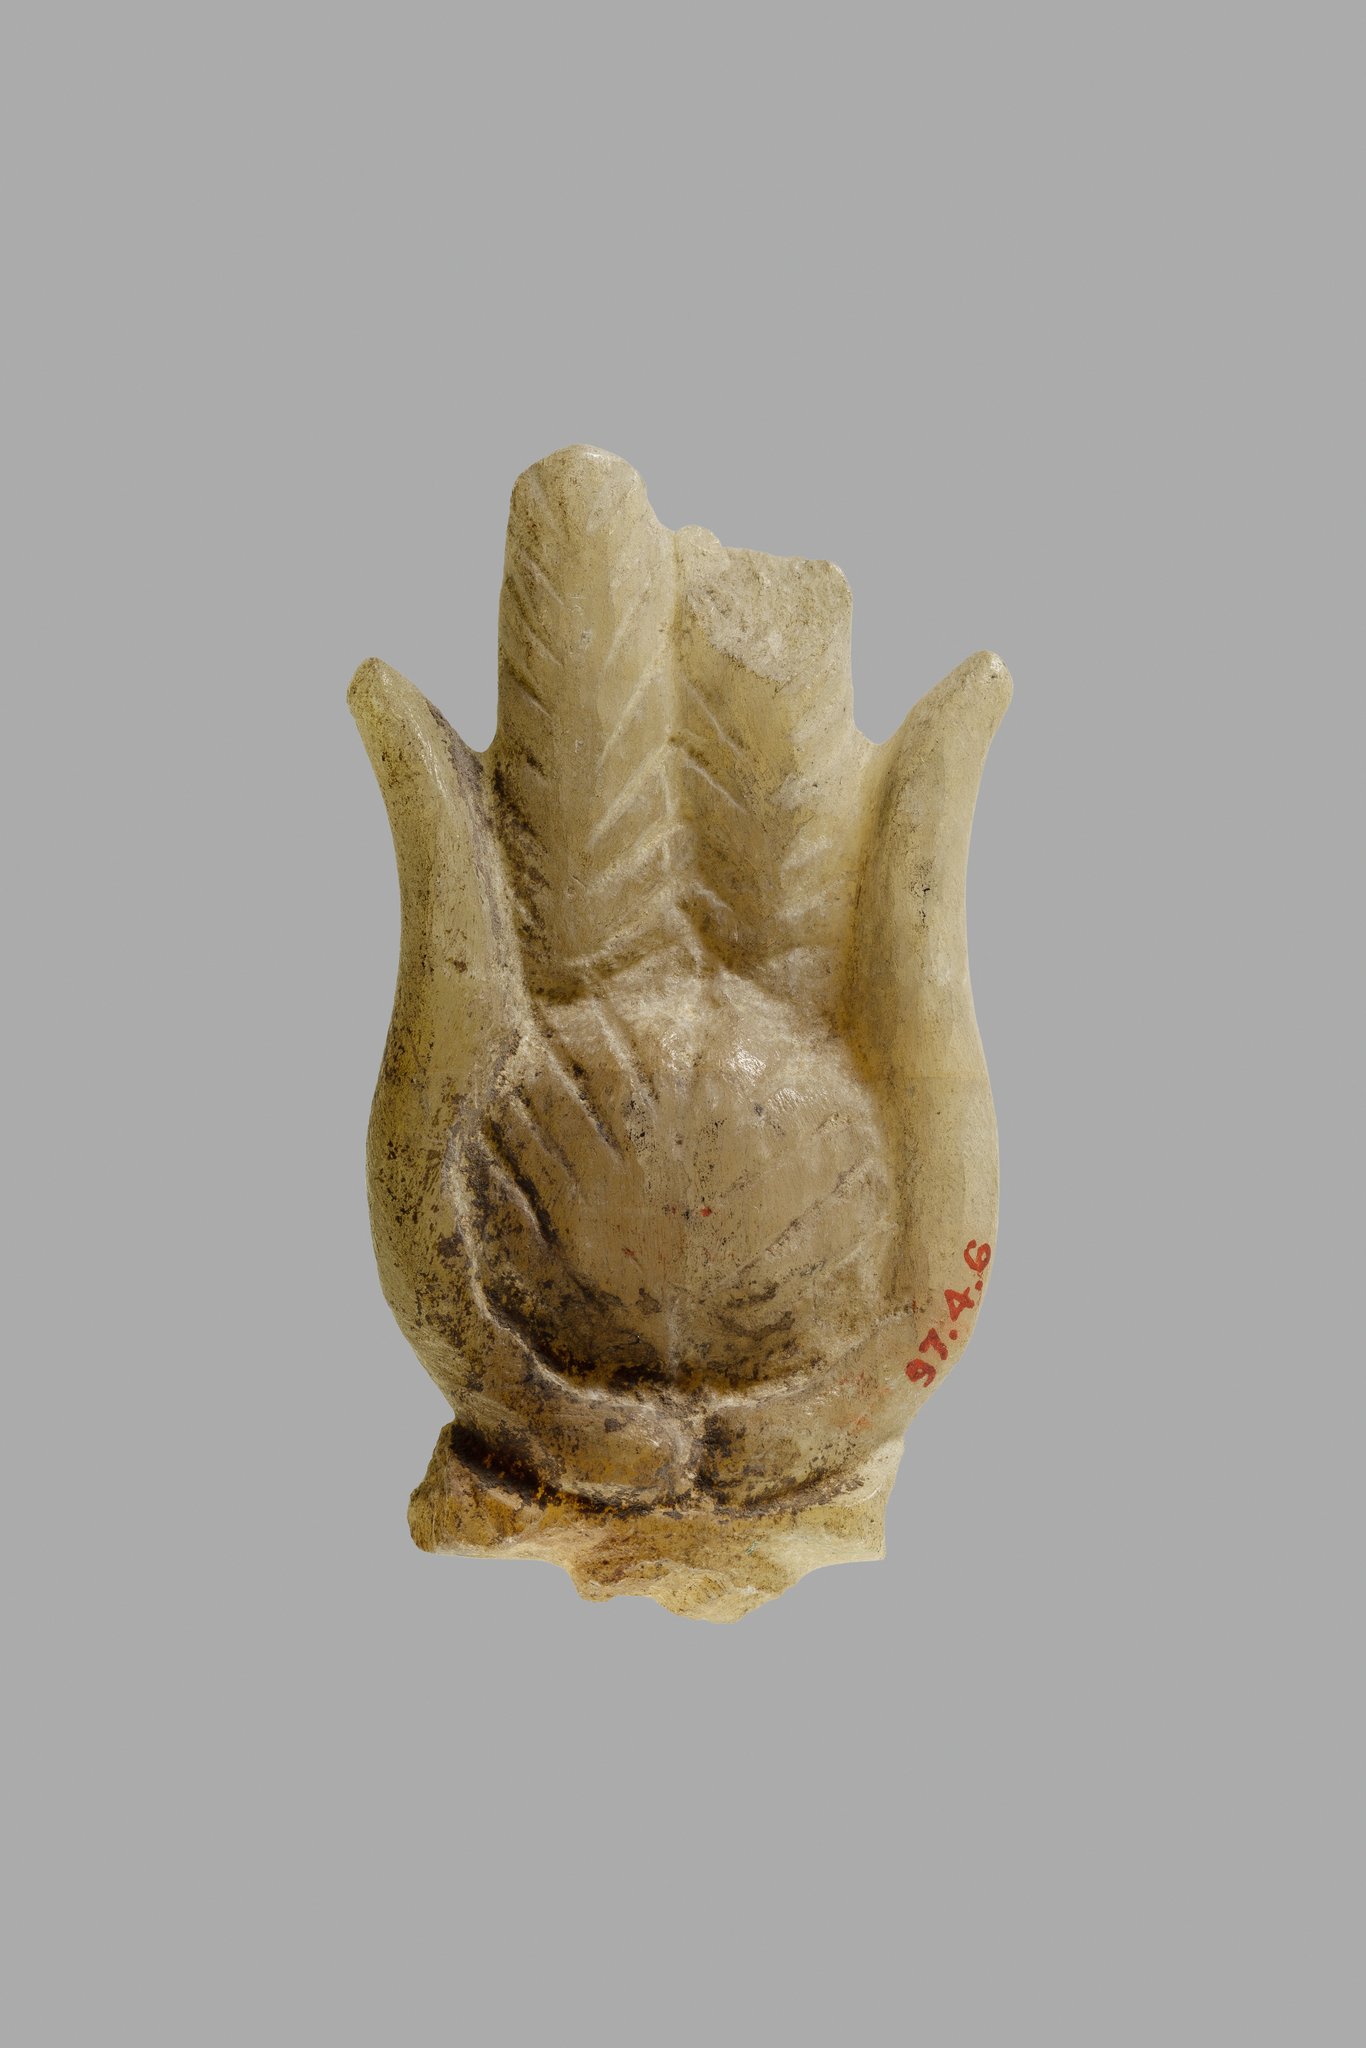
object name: statuette attachment, headress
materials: stone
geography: egypt